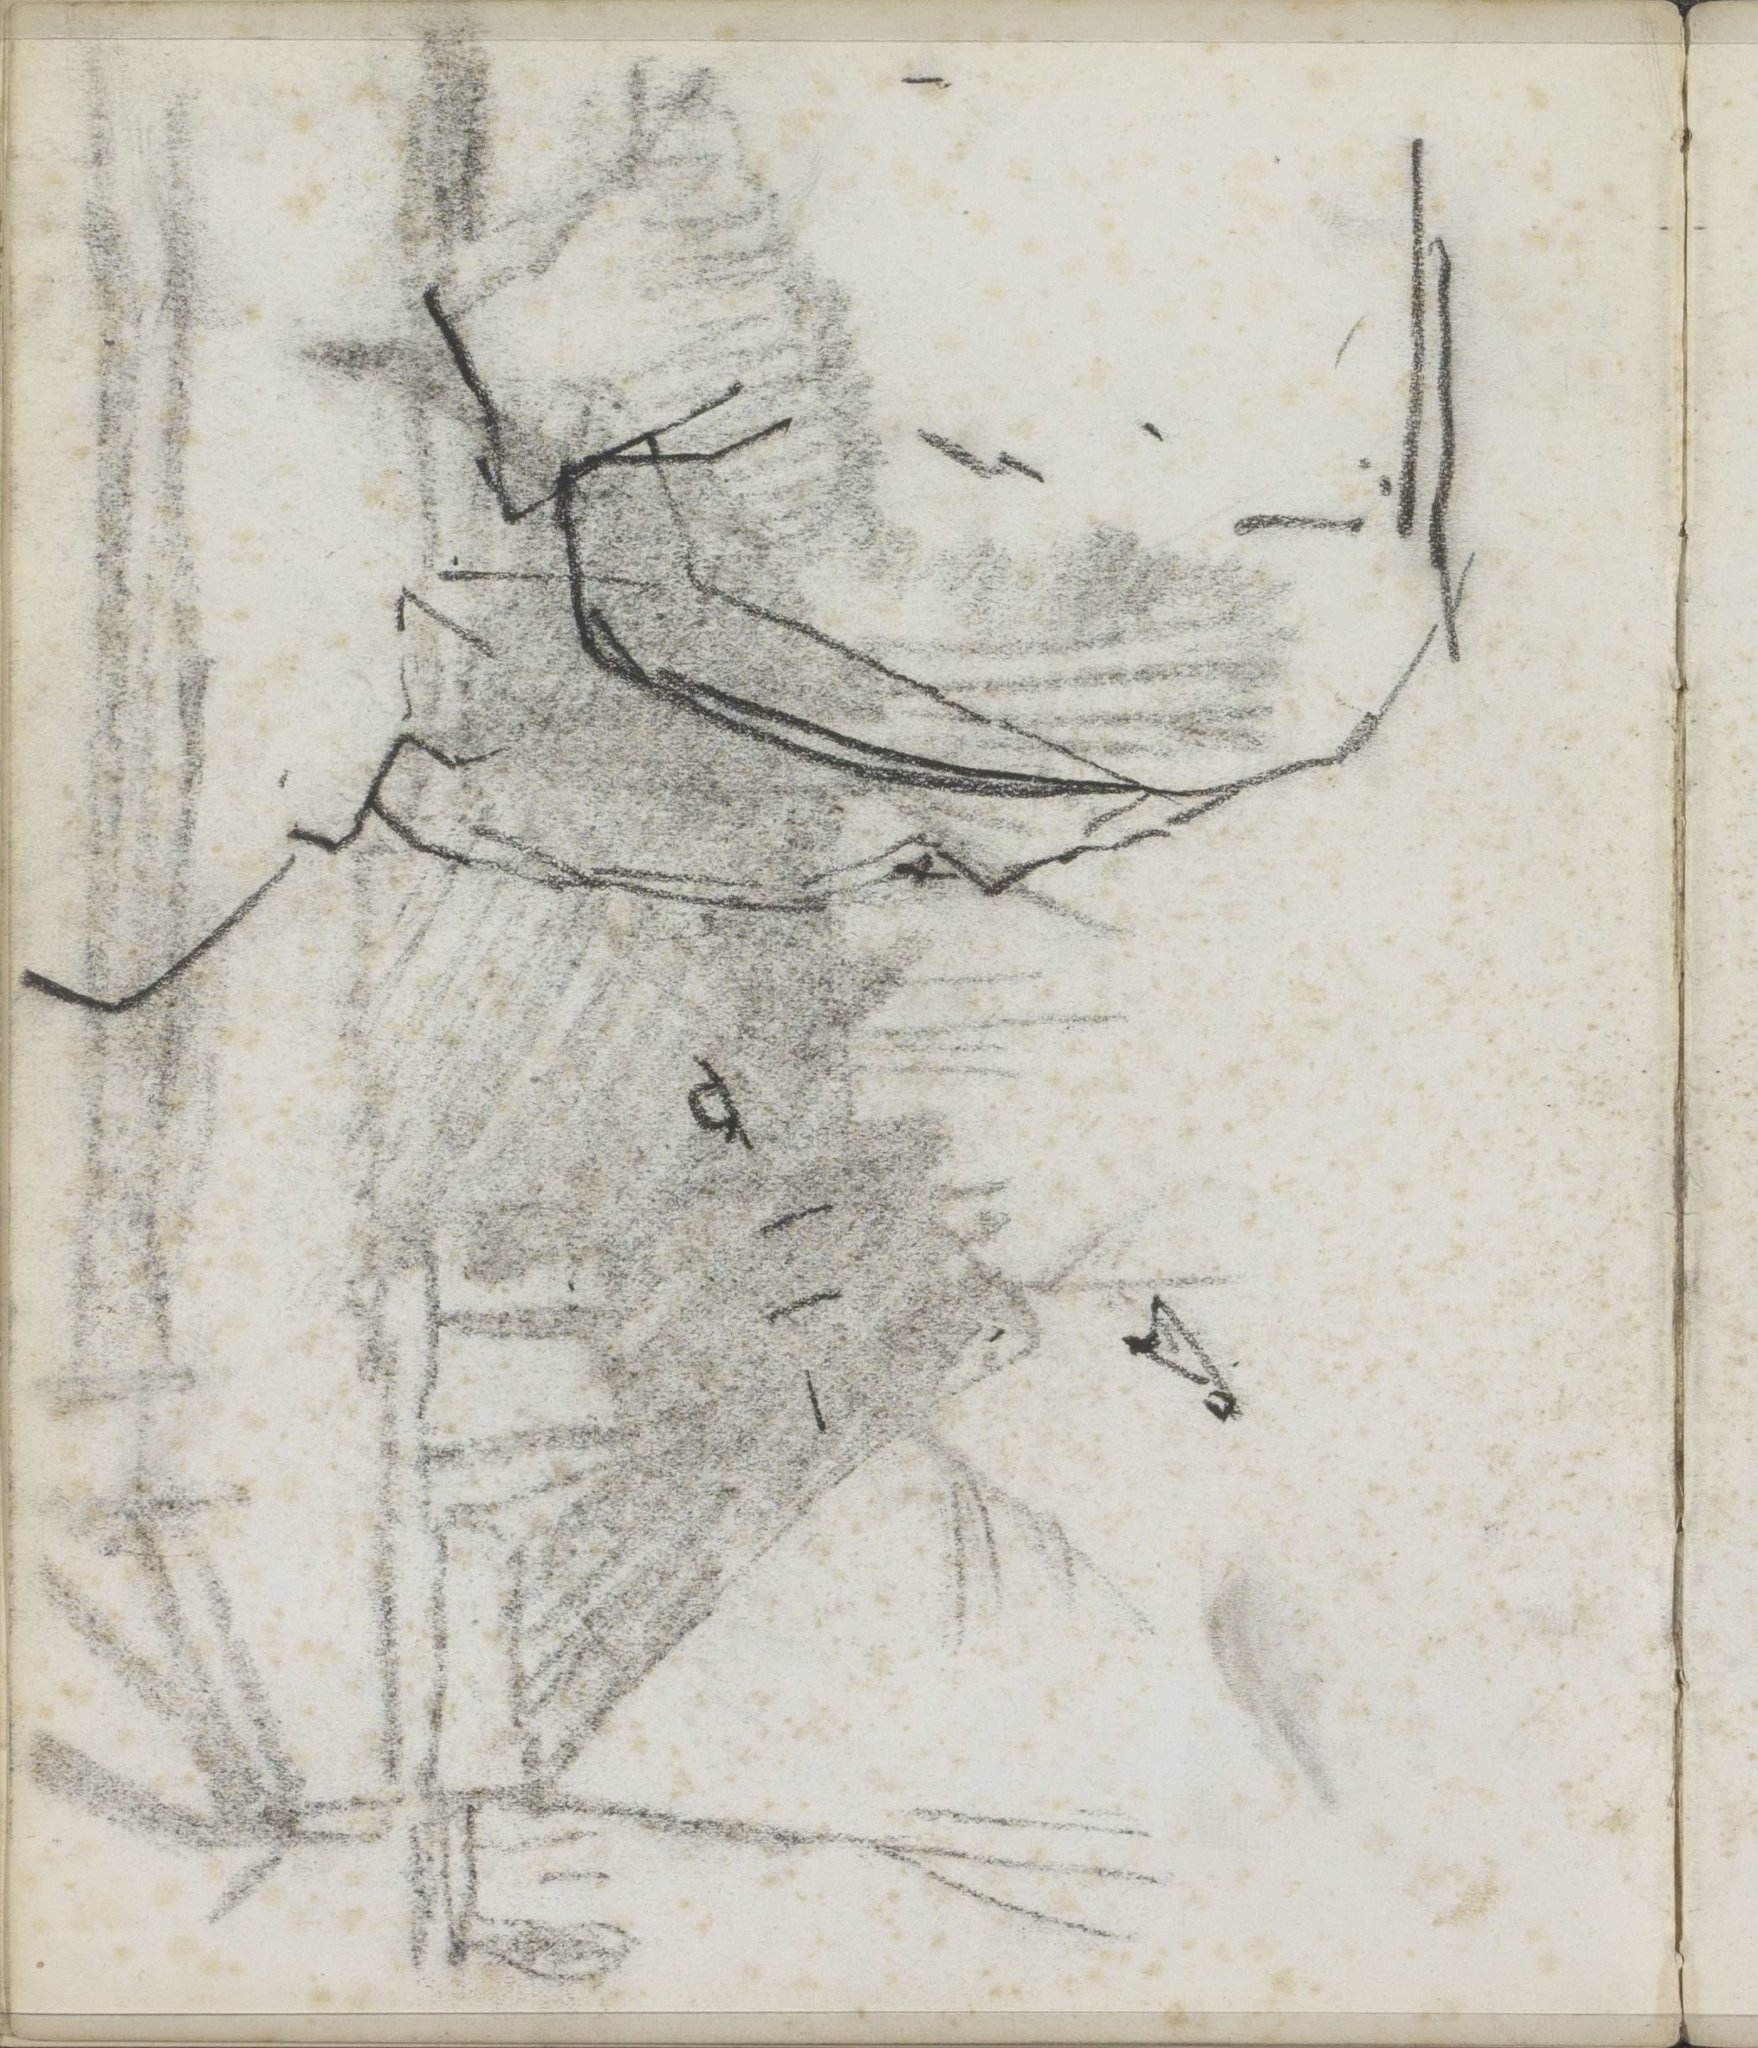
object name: sketchbook leaf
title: Studie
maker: george hendrik breitner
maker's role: draughtsman, painter, print maker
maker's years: 1857-1923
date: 1880-1906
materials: chalk, paper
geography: netherlands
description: Pagina 121 uit een schetsboek met 81 bladen.